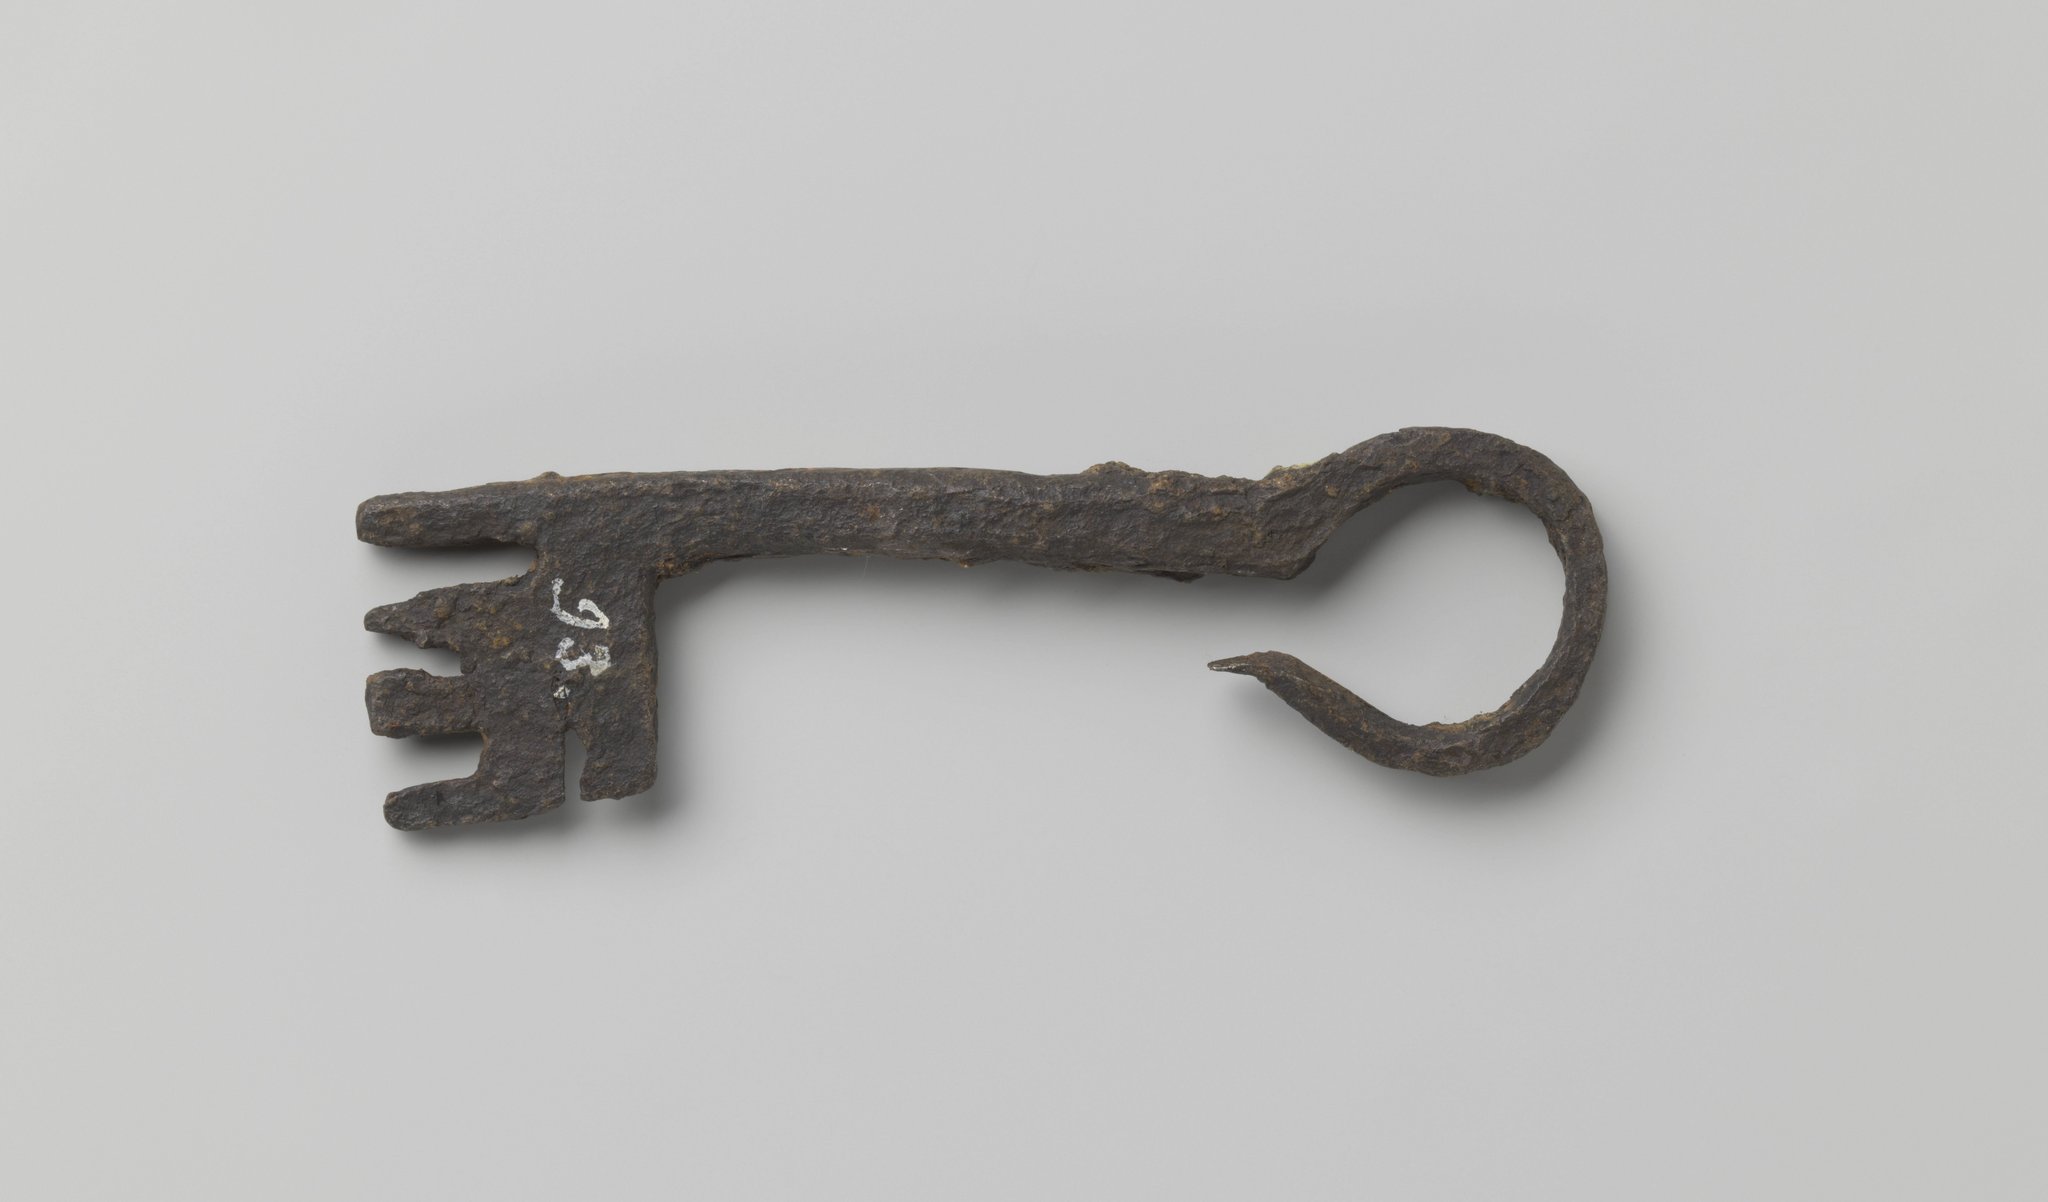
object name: key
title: Sleutel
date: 1300-1500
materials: iron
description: Sleutel waarvan de naar boven puntig toelopende steel in een oog omgebogen is. De vierkante baard vertoont grove insnijdingen.